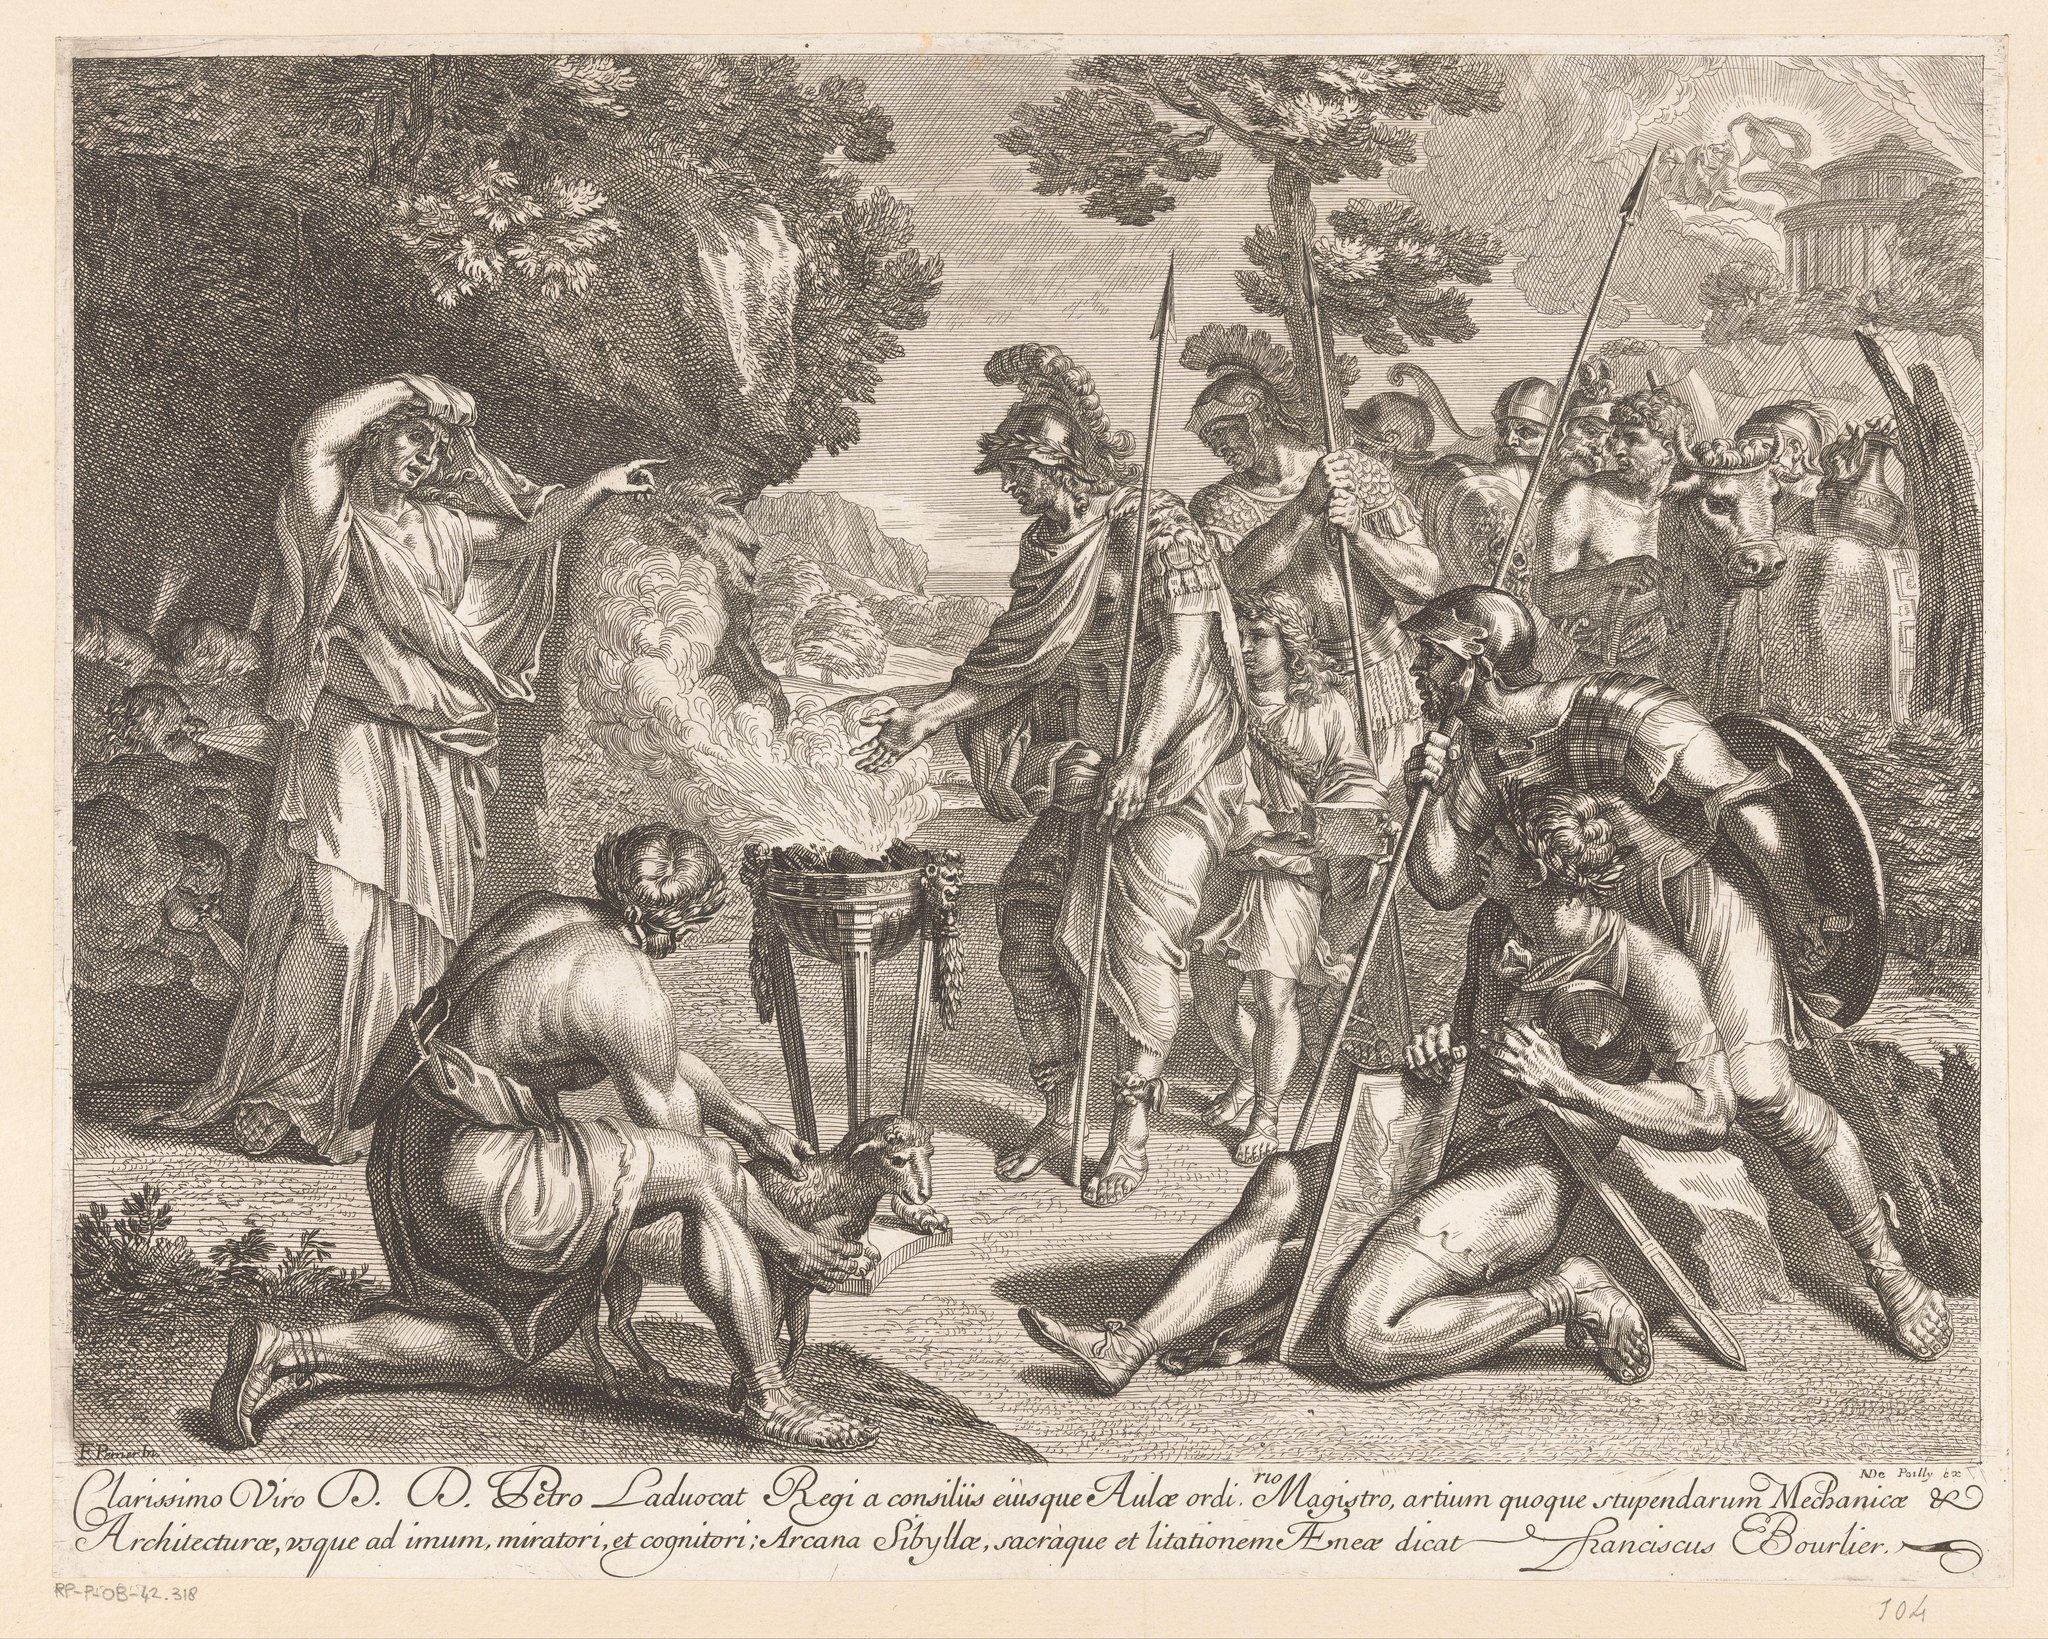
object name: print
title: Aeneas bij de sibylle Arcana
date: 1651-1682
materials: paper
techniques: engraving, etching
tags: sibyls, the story of aeneas' wanderings to italy (virgil, aeneid)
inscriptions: collector's mark: Lugt 240